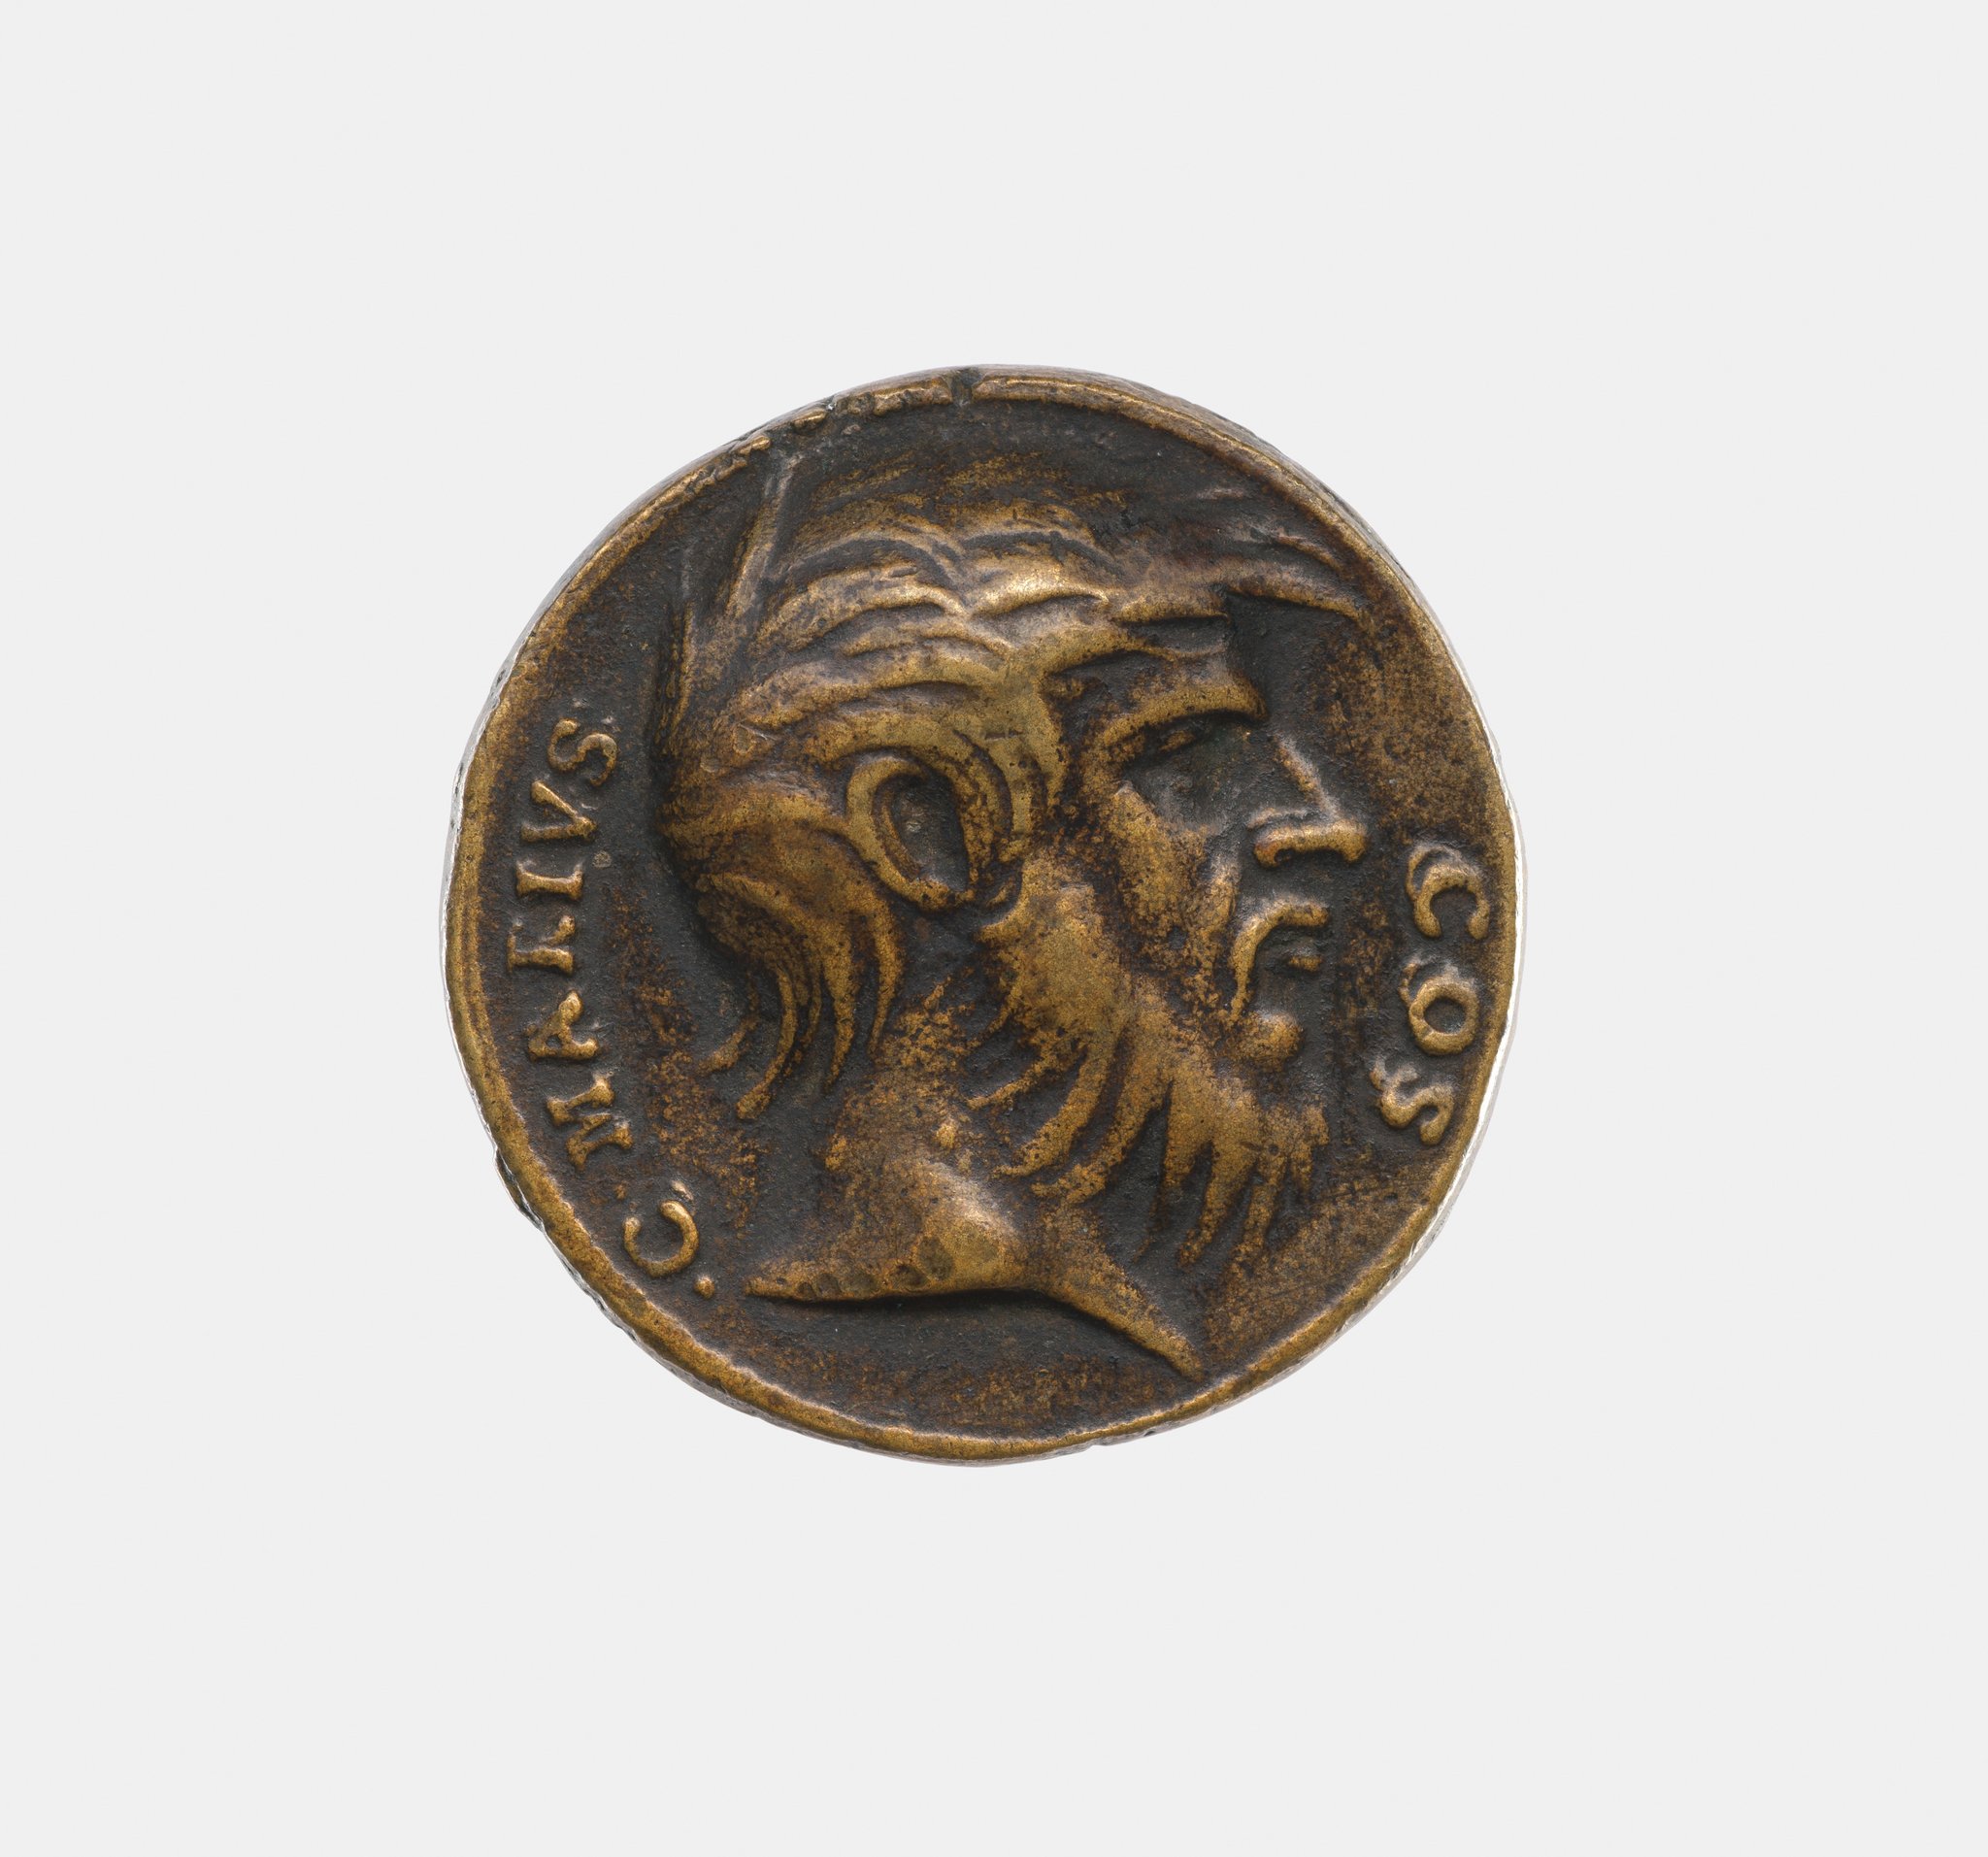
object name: medal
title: Gaius Marius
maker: valerio belli (il vicentino)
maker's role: artist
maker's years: 1468-1546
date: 1468-1546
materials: bronze